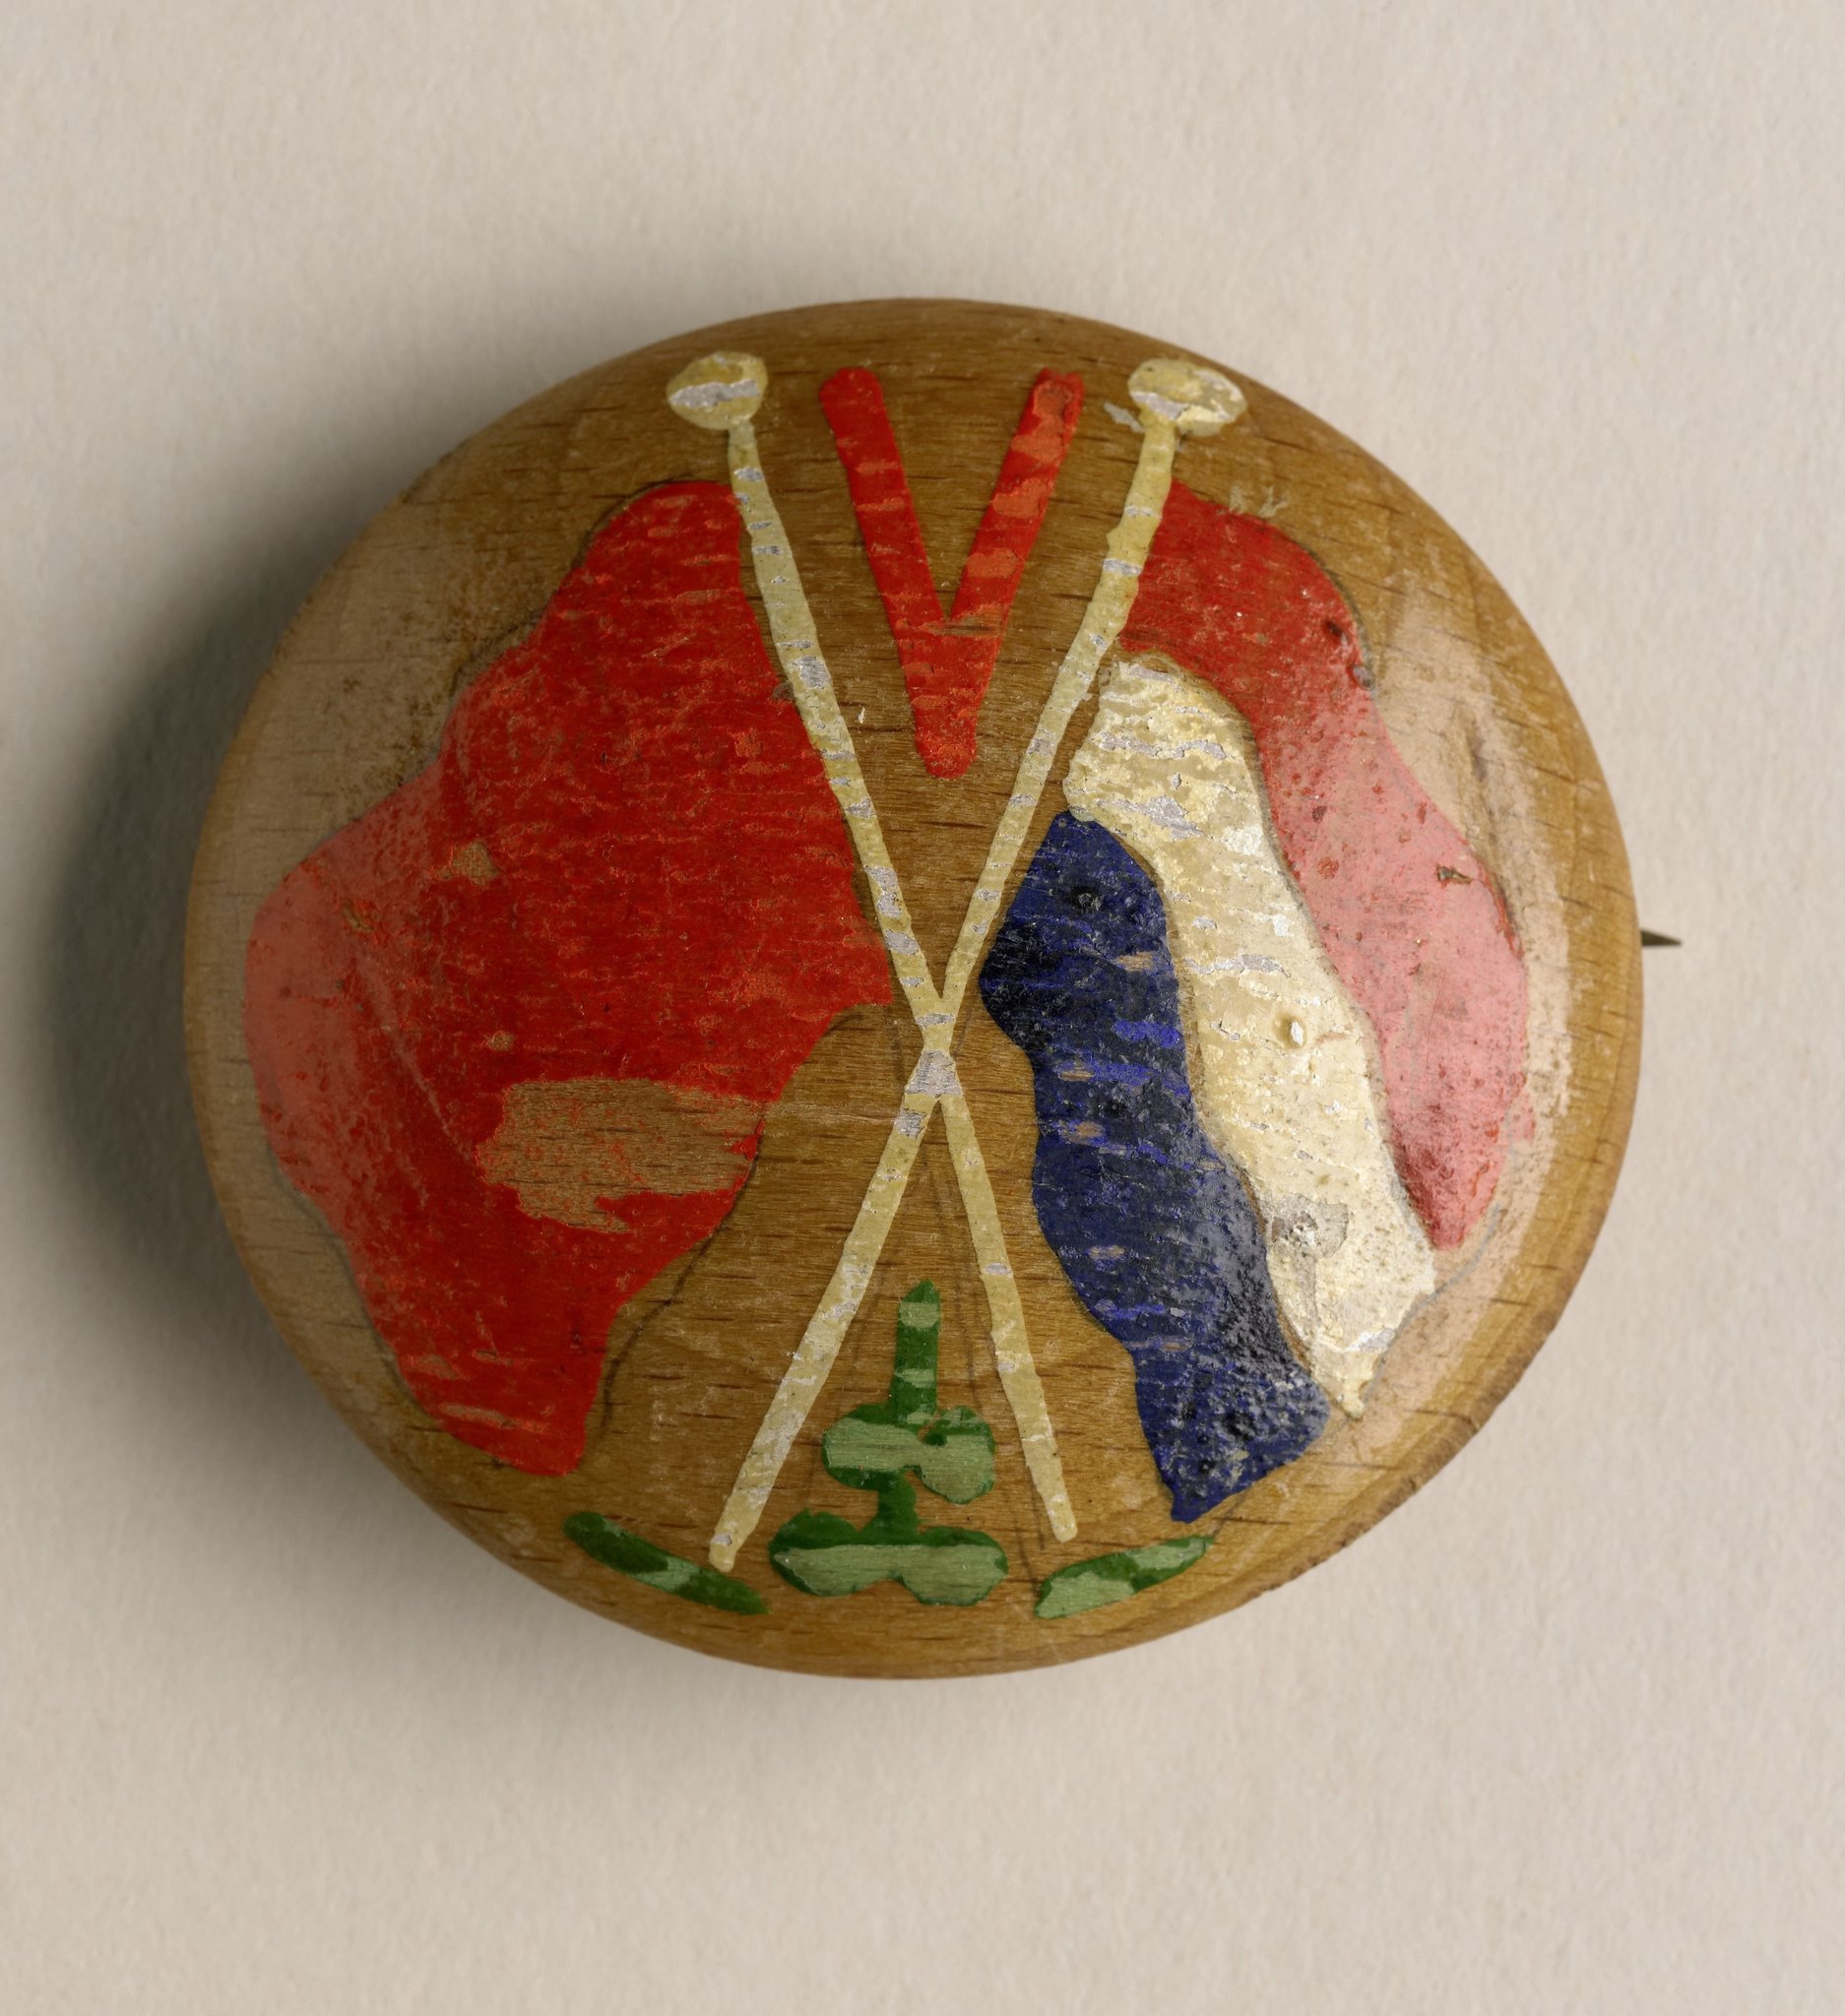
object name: insignia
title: Broche gemaakt naar aanleiding van de bevrijding van Nederland op 5 mei 1945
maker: Anonymous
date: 1945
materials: paint, wood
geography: netherlands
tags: netherlands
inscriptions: inscription: ‘5 mei 1945’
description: Broche gemaakt naar aanleiding van de bevrijding van Nederland op 5 mei 1945. De houten broche is beschilderd met 2 gekruiste vlaggenstokken, met links een oranje vlag en rechts de rood wit blauwe vlag.De verf van de oranje vlag is gedeeltelijk afgebladderd. Bovenaan, tussen de vlaggenstokken in, is met oranje een V geschilderd, verwijzend naar het woord vrijheid. Onderaan is met groen de suggestie gewekt van begroeing, mogelijk als symbool voor een nieuw begin. Op de achterzijde is een eenvoudige speld aangebracht en de datum 5 mei 1945 met inkt.